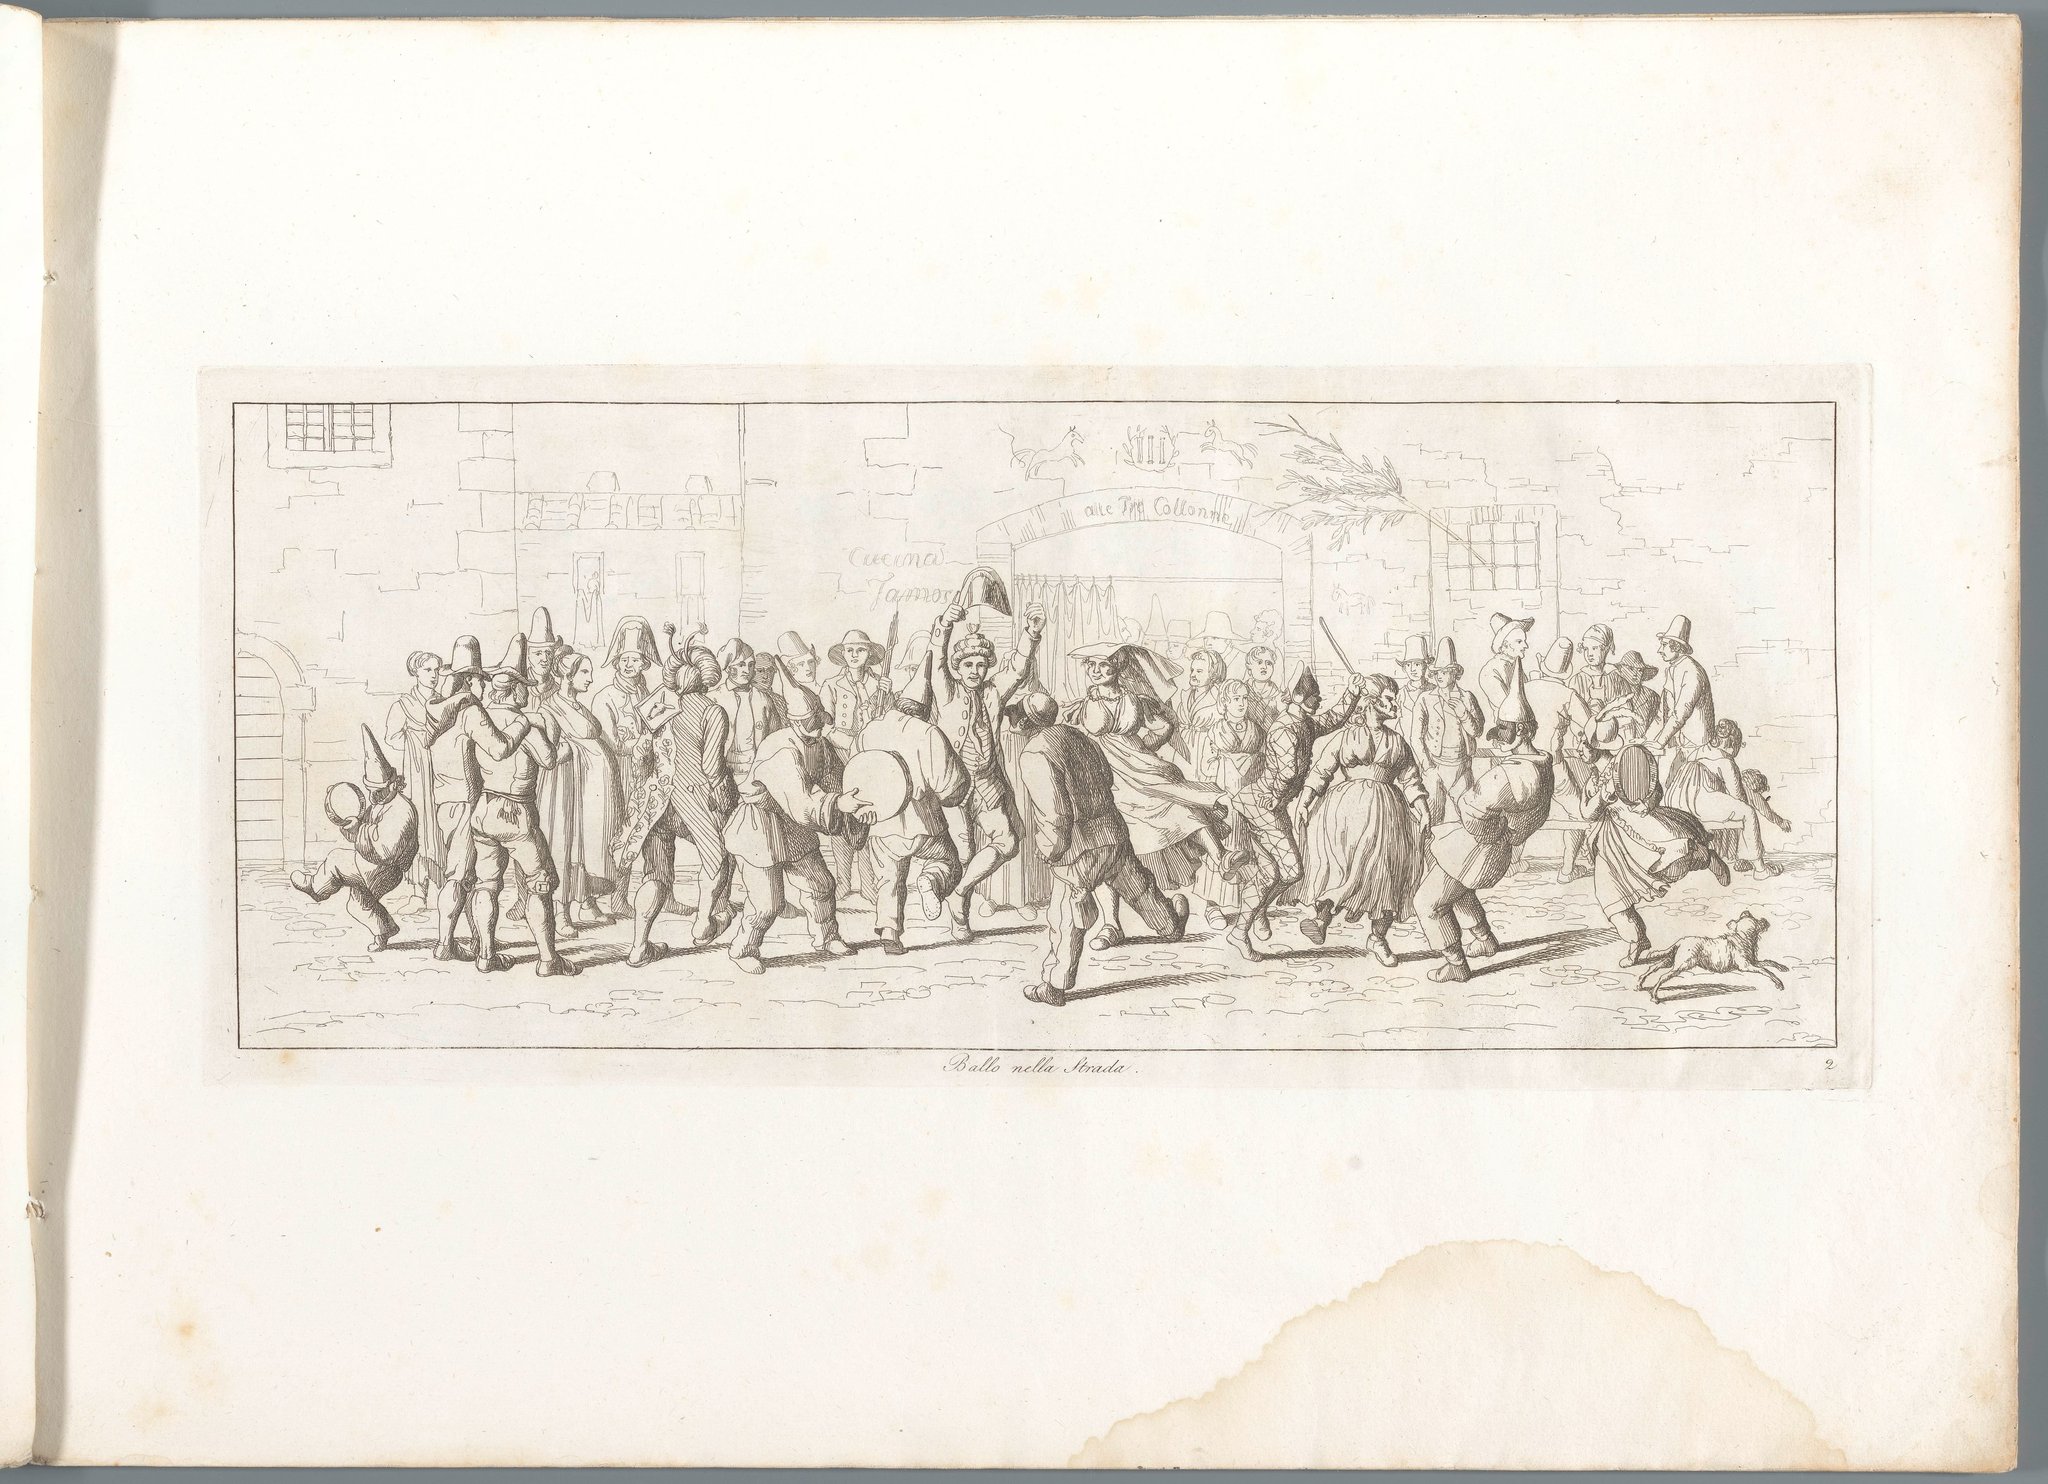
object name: print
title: Il Carnevale di Roma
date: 1820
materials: paper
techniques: etching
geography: rome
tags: carnival, shrovetide (non-liturgical celebration), pavement, terrace in front of inn or restaurant, rome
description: Verklede dansende feestgangers op straat voor het restaurant 'alle tre Collonne'. Onderdeel van een prentwerk met een serie van twintig prenten over de viering van carnaval in Rome.